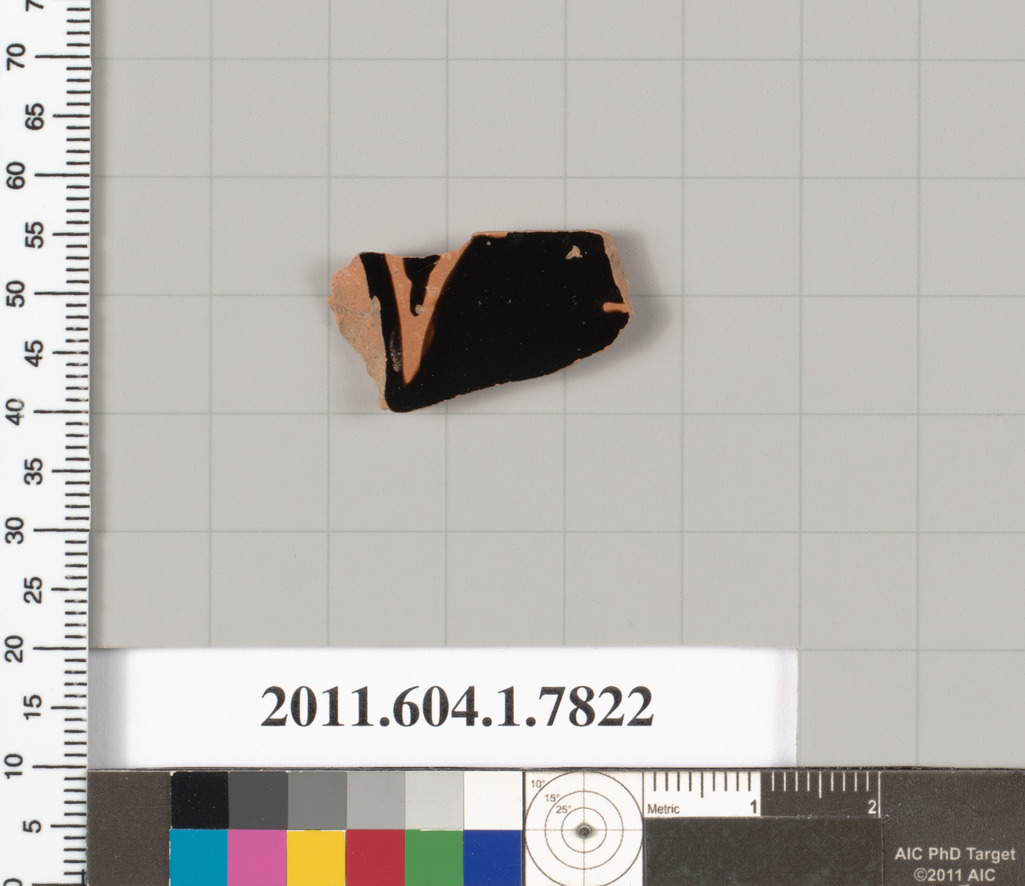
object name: kylix fragment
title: Terracotta fragment of a kylix (drinking cup)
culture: greek, attic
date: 460-450 BCE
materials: terracotta